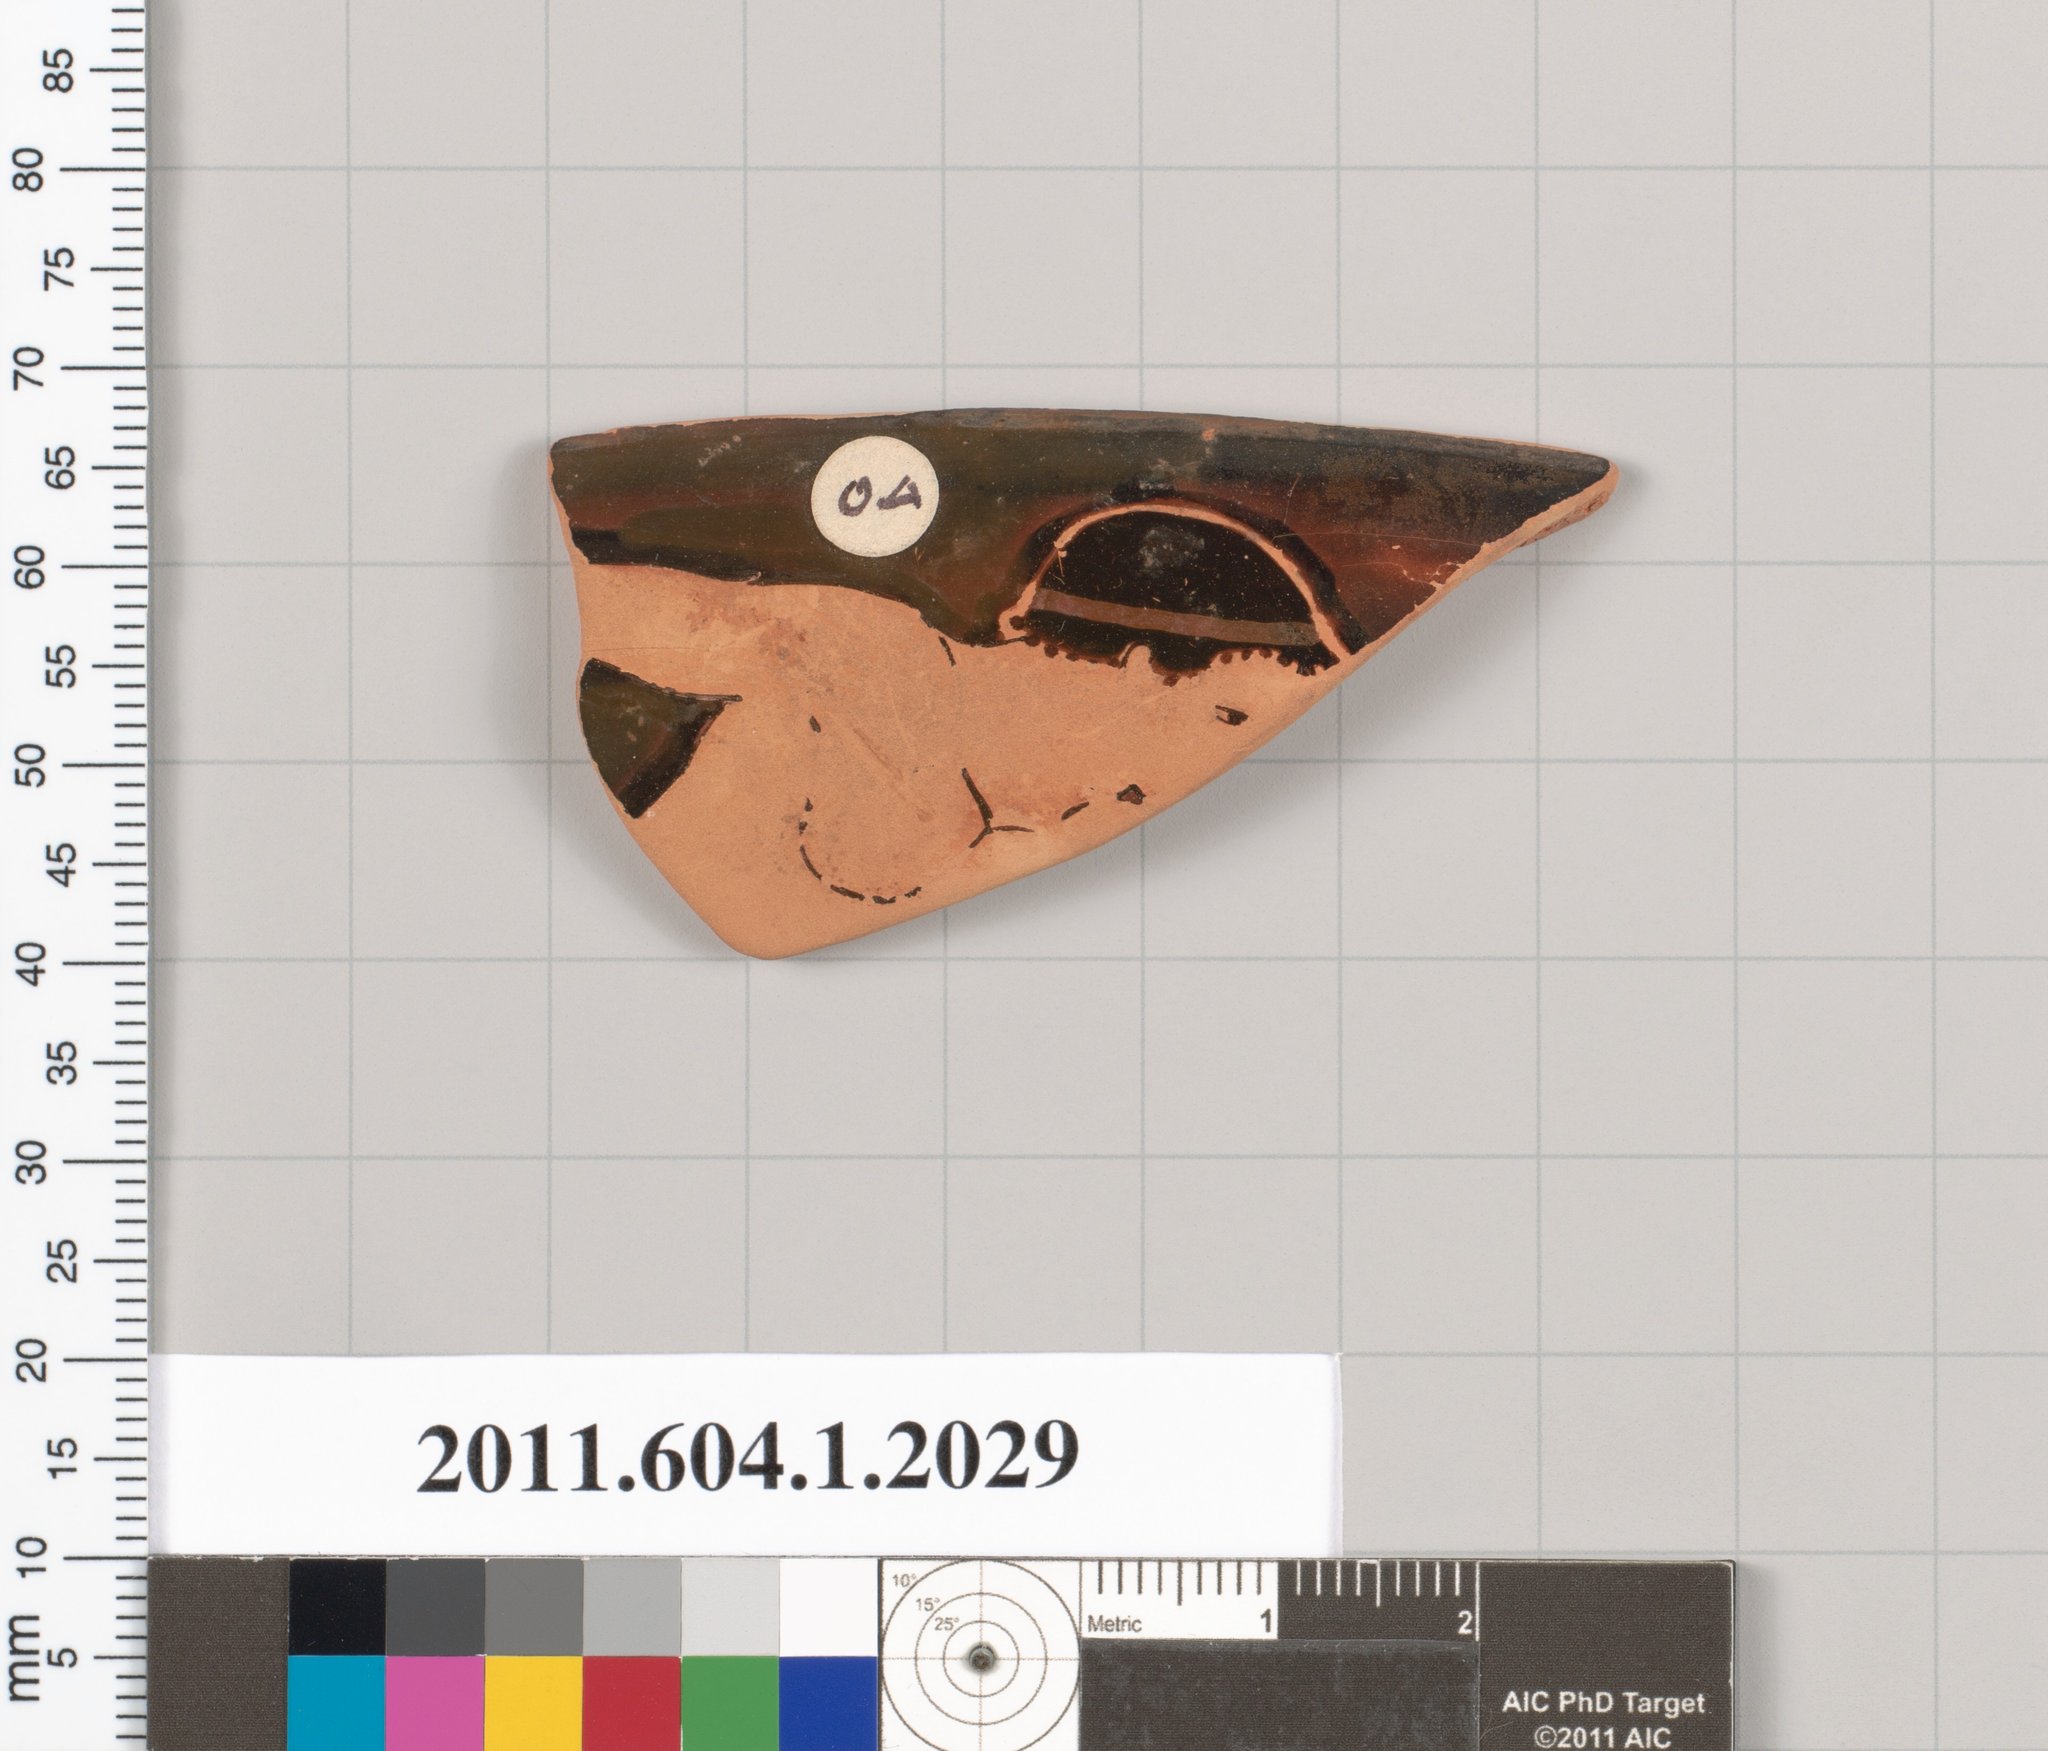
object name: kylix fragment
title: Terracotta rim fragment of a kylix (drinking cup)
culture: greek, attic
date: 500-468 BCE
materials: terracotta